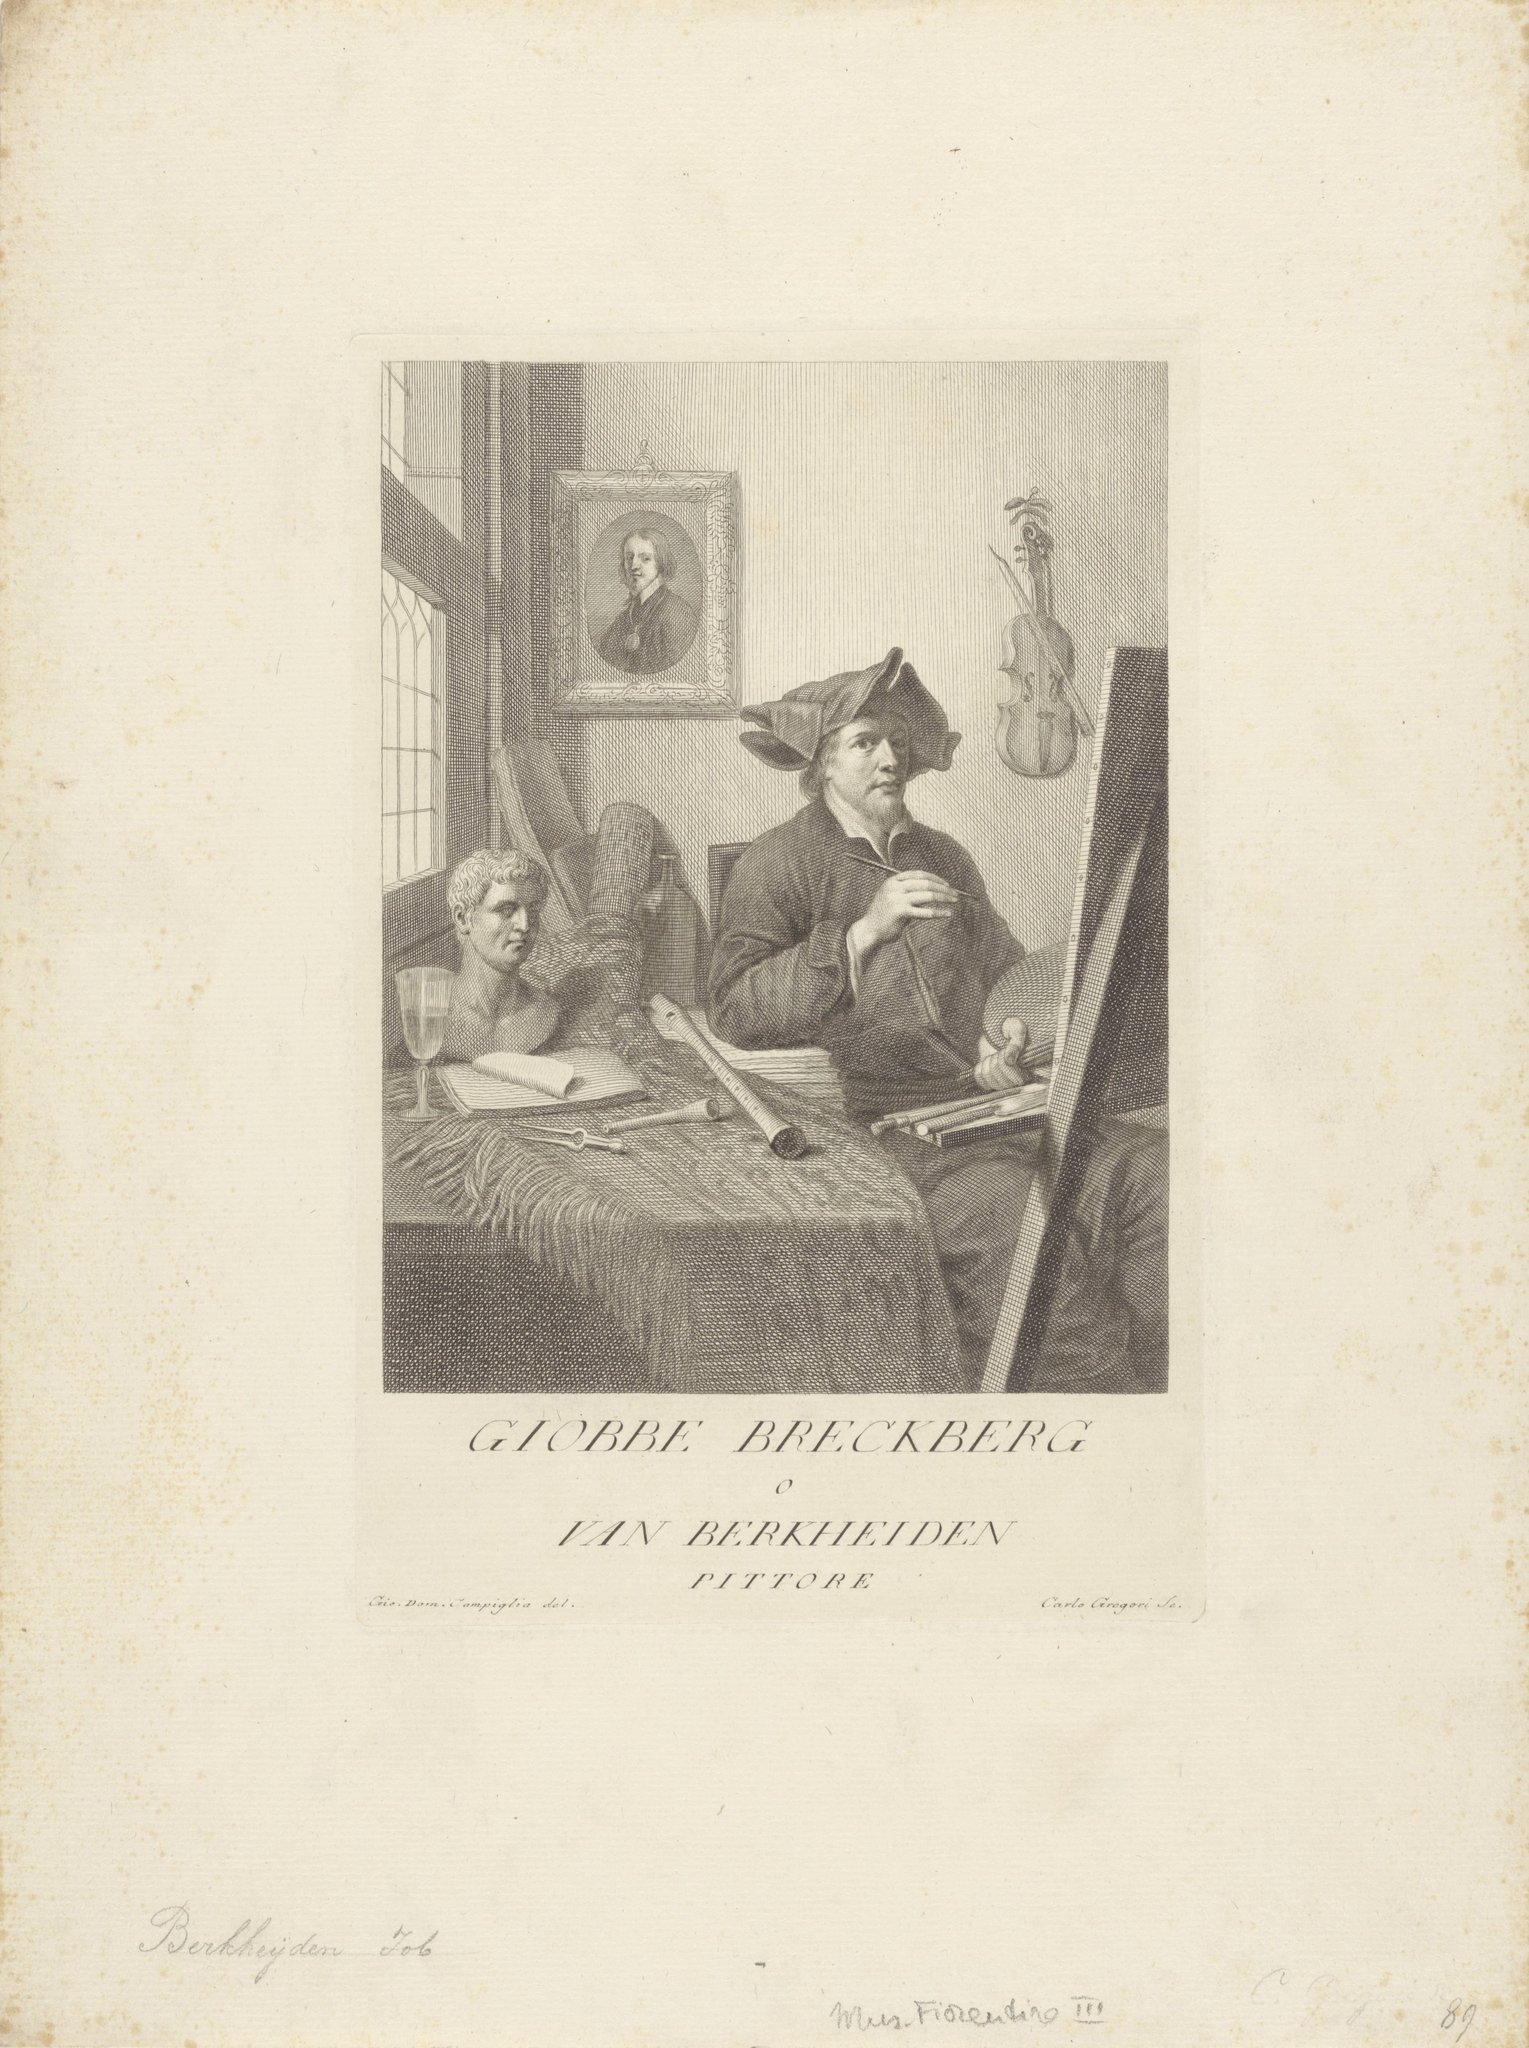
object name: print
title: Portretten van kunstenaars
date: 1752-1762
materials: paper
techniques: engraving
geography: italy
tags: haarlem, painter, draughtsman, job adriaensz berckheyde, historical persons, violin, fiddle, portrait, self-portrait of painter, recorder (musical instrument)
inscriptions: collector's mark: ‘RIJKS / MUSM’, collector's mark: Lugt 2760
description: Jacob Berckehyde, zittend achter zijn schildersezel, met palet en penseel in de hand. Linksvoor een tafel waarop een blokfluit, passer, boek, gipsen buste en glas liggen. Aan de muur hangen een viool en een portret.